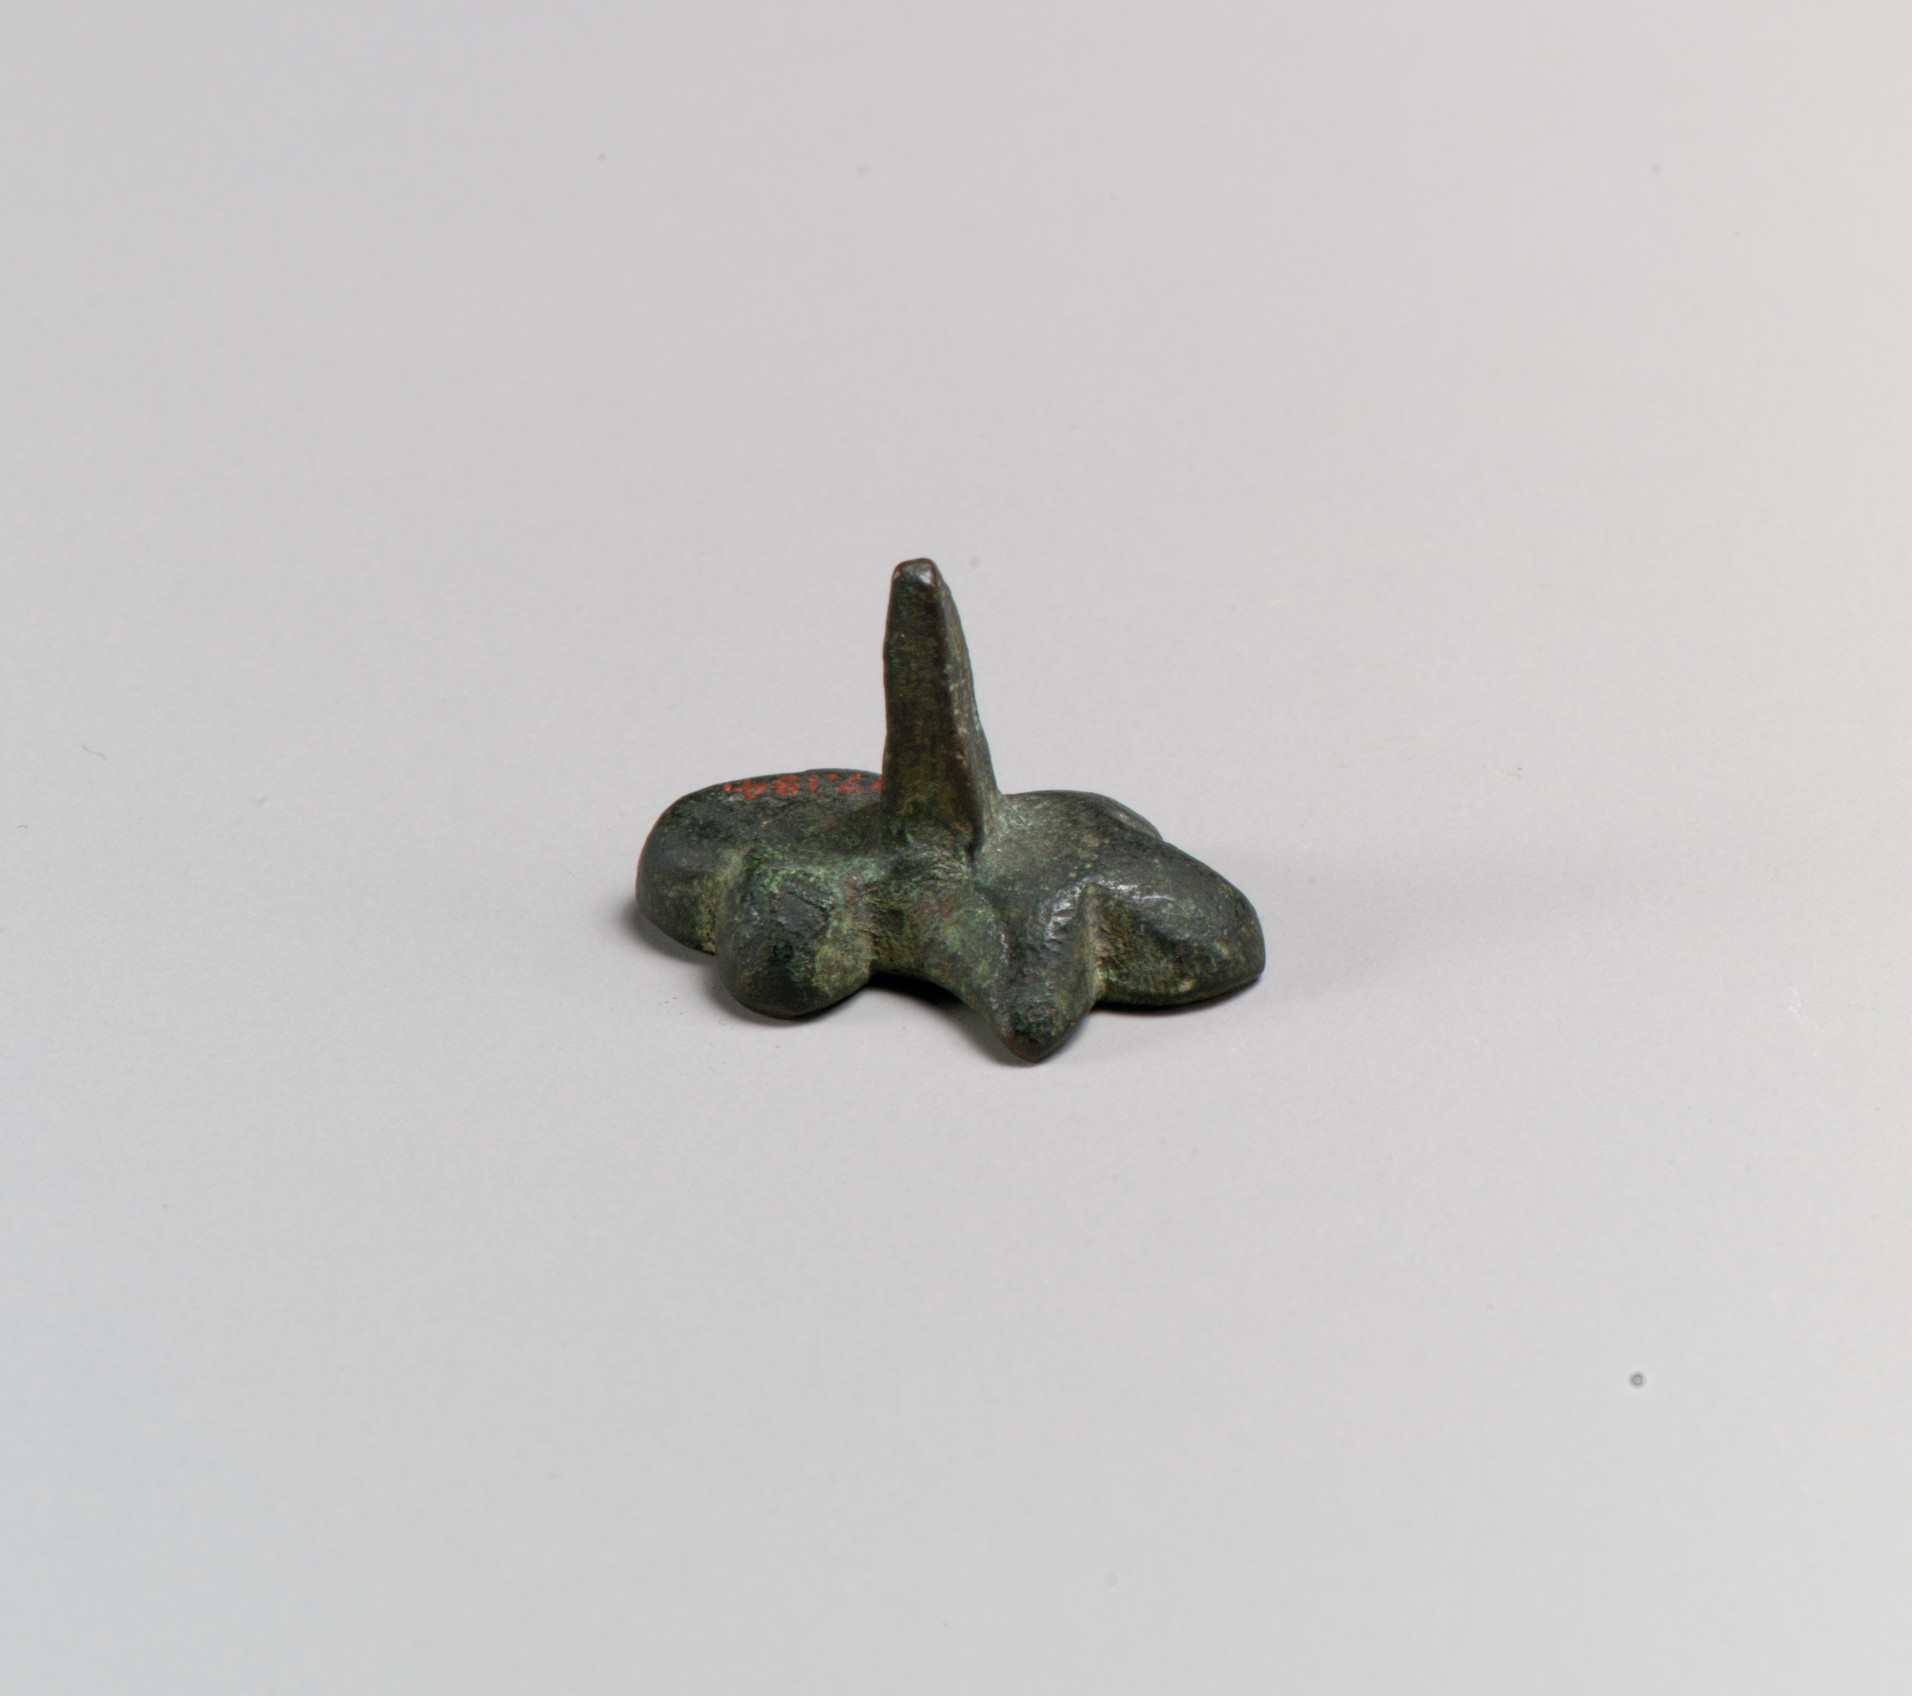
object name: ornament, stud or matrix for an ornament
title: Ornament, stud or matrix for an ornament ?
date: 7000 BCE-330 CE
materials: bronze